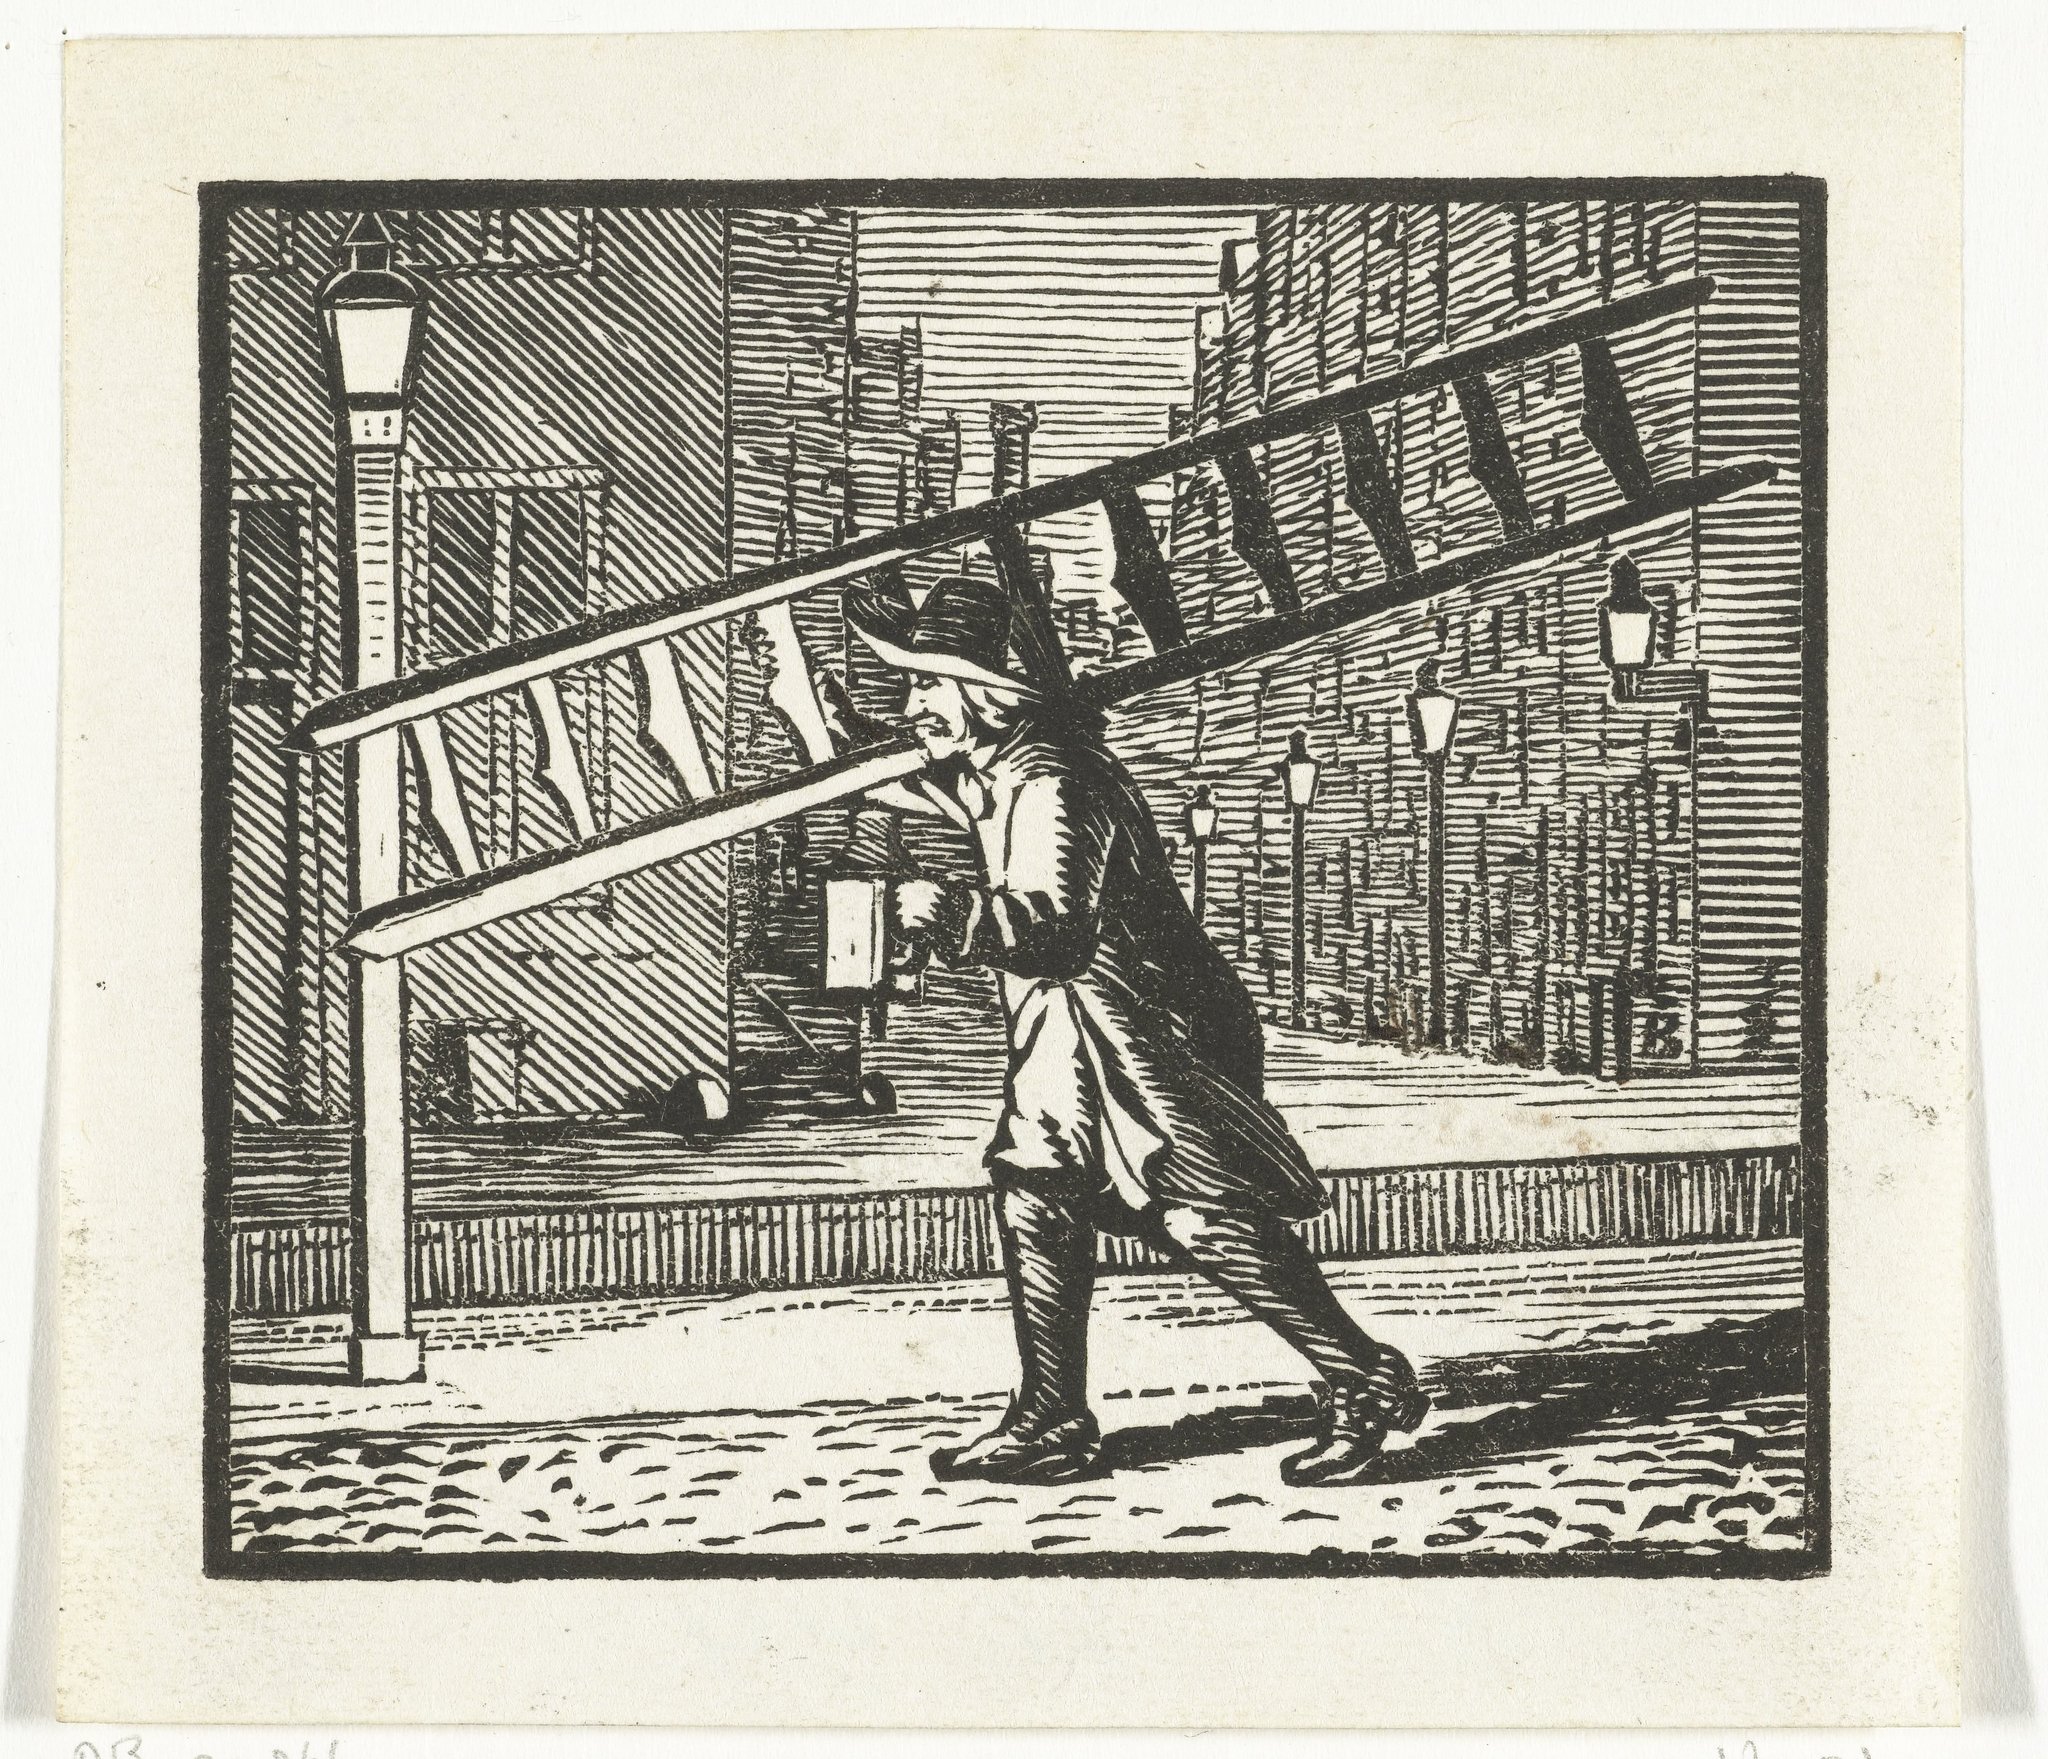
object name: print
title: Lantaarnopsteker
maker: dirck de bray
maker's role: draughtsman, painter, print maker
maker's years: 1625-1694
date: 1635-1694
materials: paper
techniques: woodcut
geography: netherlands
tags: oil-lamp (+ kindling a light; lit, burning light, lamp, candle), ladder, street lighting, street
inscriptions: collector's mark: Lugt 240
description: Een lantaarnopsteker loopt door de straten met een ladder op zijn schouder en een lantaarn in zijn hand.